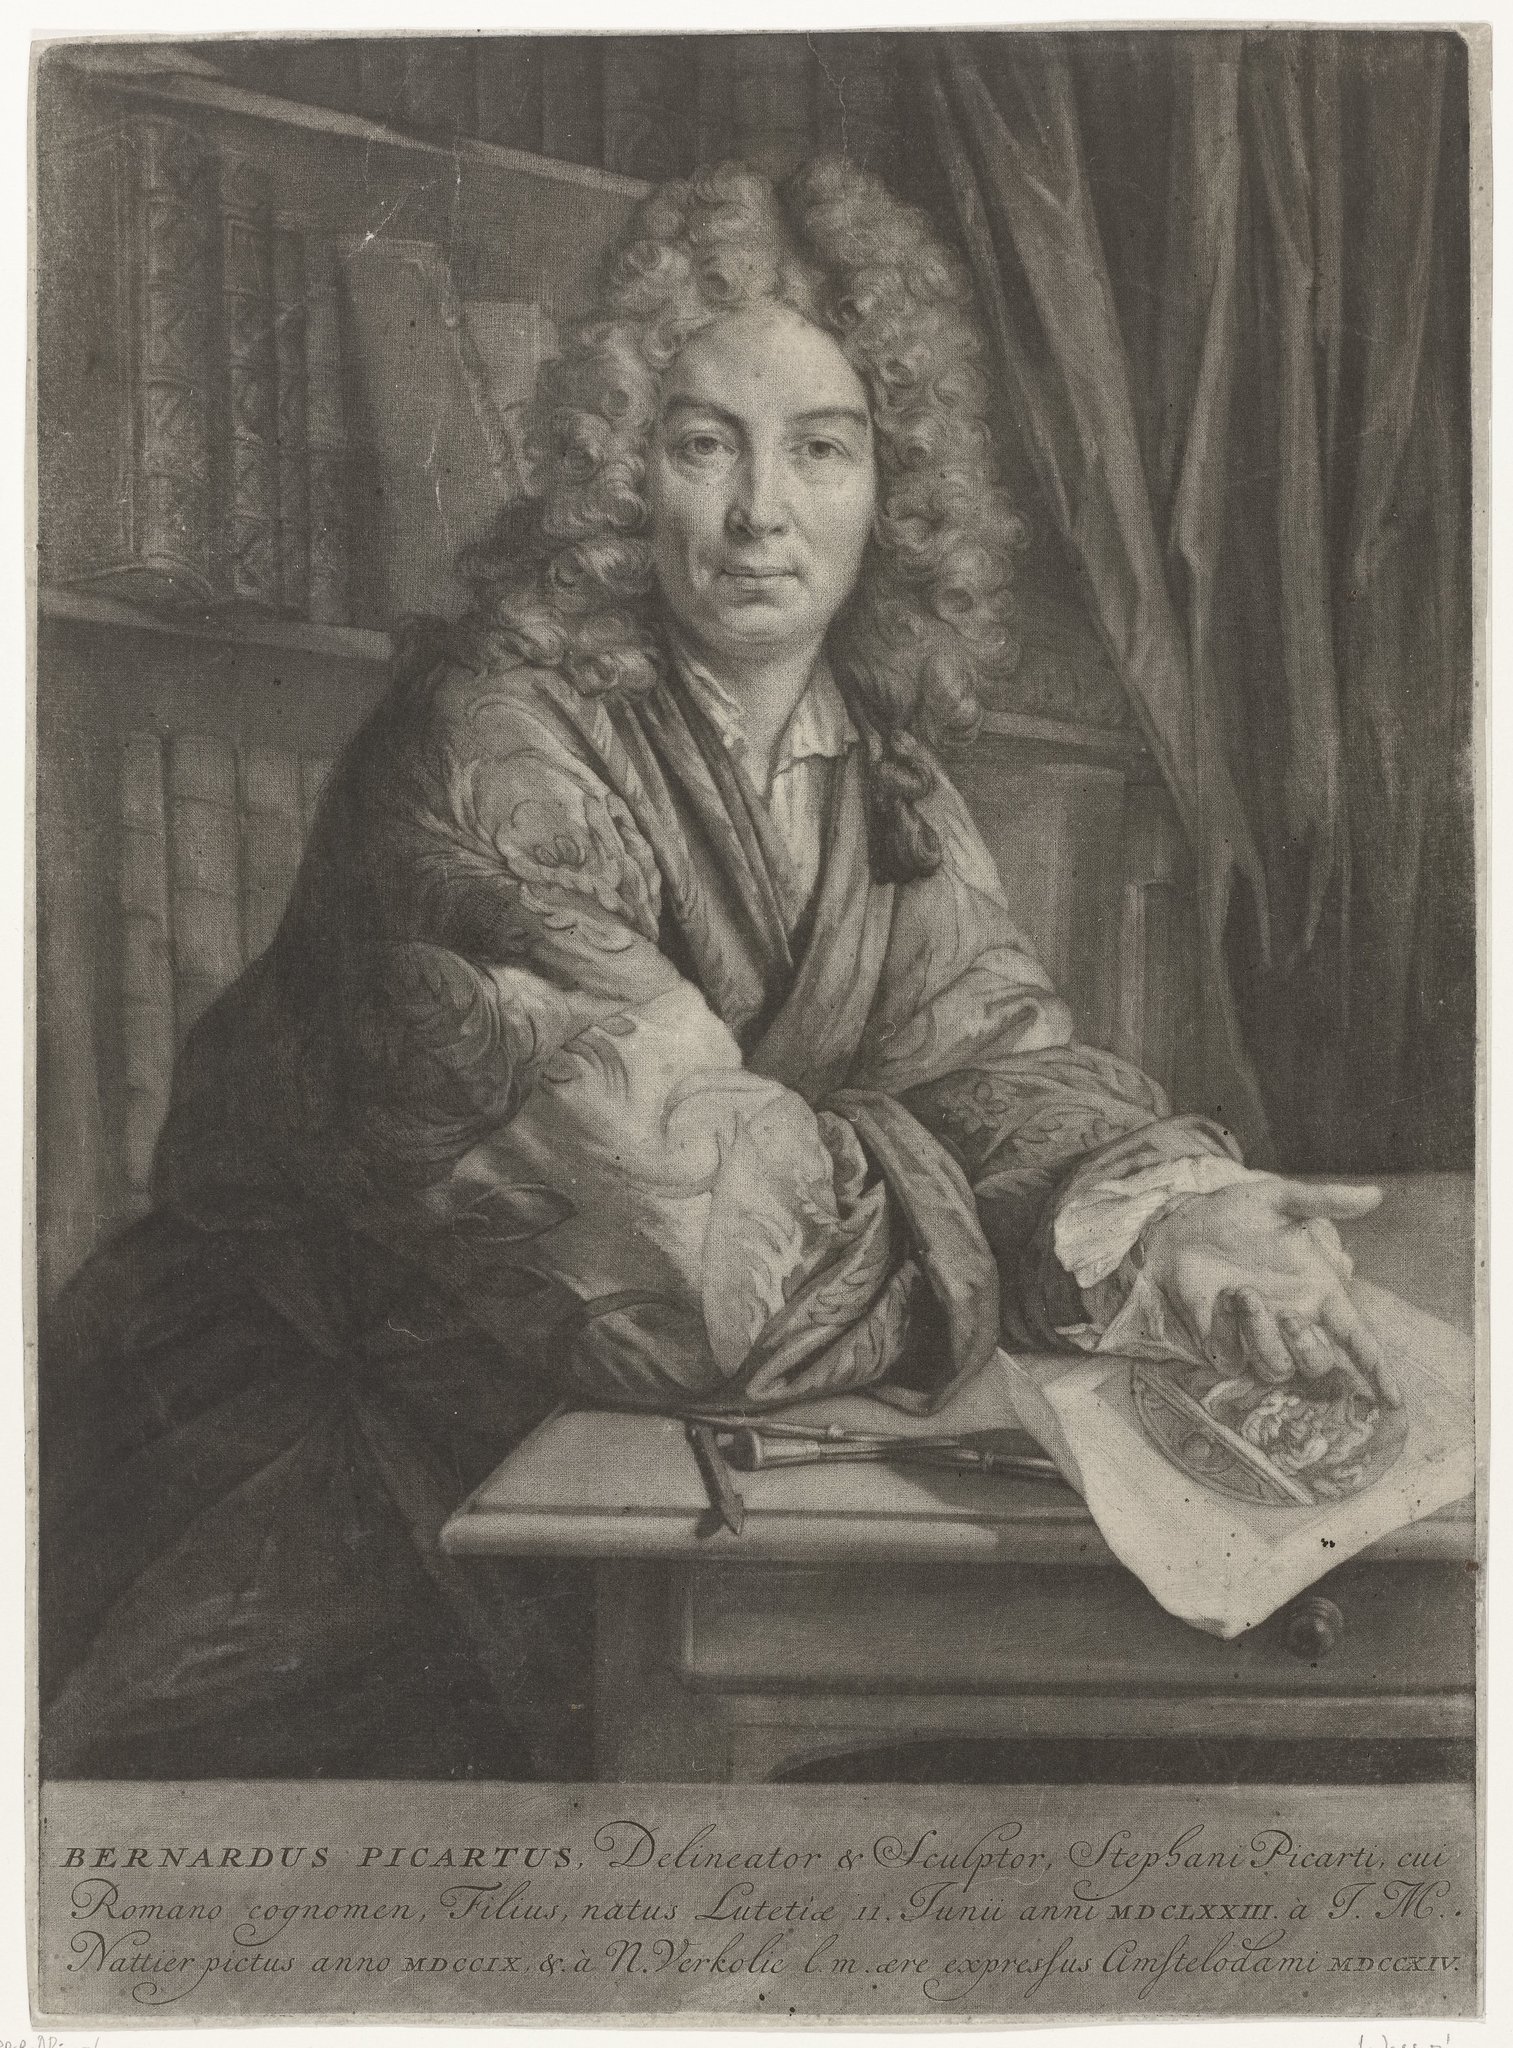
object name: print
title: Portret van Bernard Picart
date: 1714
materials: paper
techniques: engraving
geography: amsterdam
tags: paris, amsterdam, print maker, draughtsman, bernard picart, print, e.g.: engraving, etching, lithograph, historical persons, book, portrait, self-portrait of artist, tools, implements of printer, gem, gemstone (+ relief ~ sculpture)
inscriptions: collector's mark: Lugt 2228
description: De tekenaar en graveur Bernard Picart zit aan een tafel en draagt een geborduurde jas. Hij wijst op zijn prent uit 1709 met daarop de antieke gesneden steen die toen bekend stond als 'Cachet de Michel Ange' maar naar een gegraveerde edelsteen van Pyrgoteles gemaakt is. Naast de prent liggen enkele graveursgereedschappen. Achter hem een groot aantal boeken.